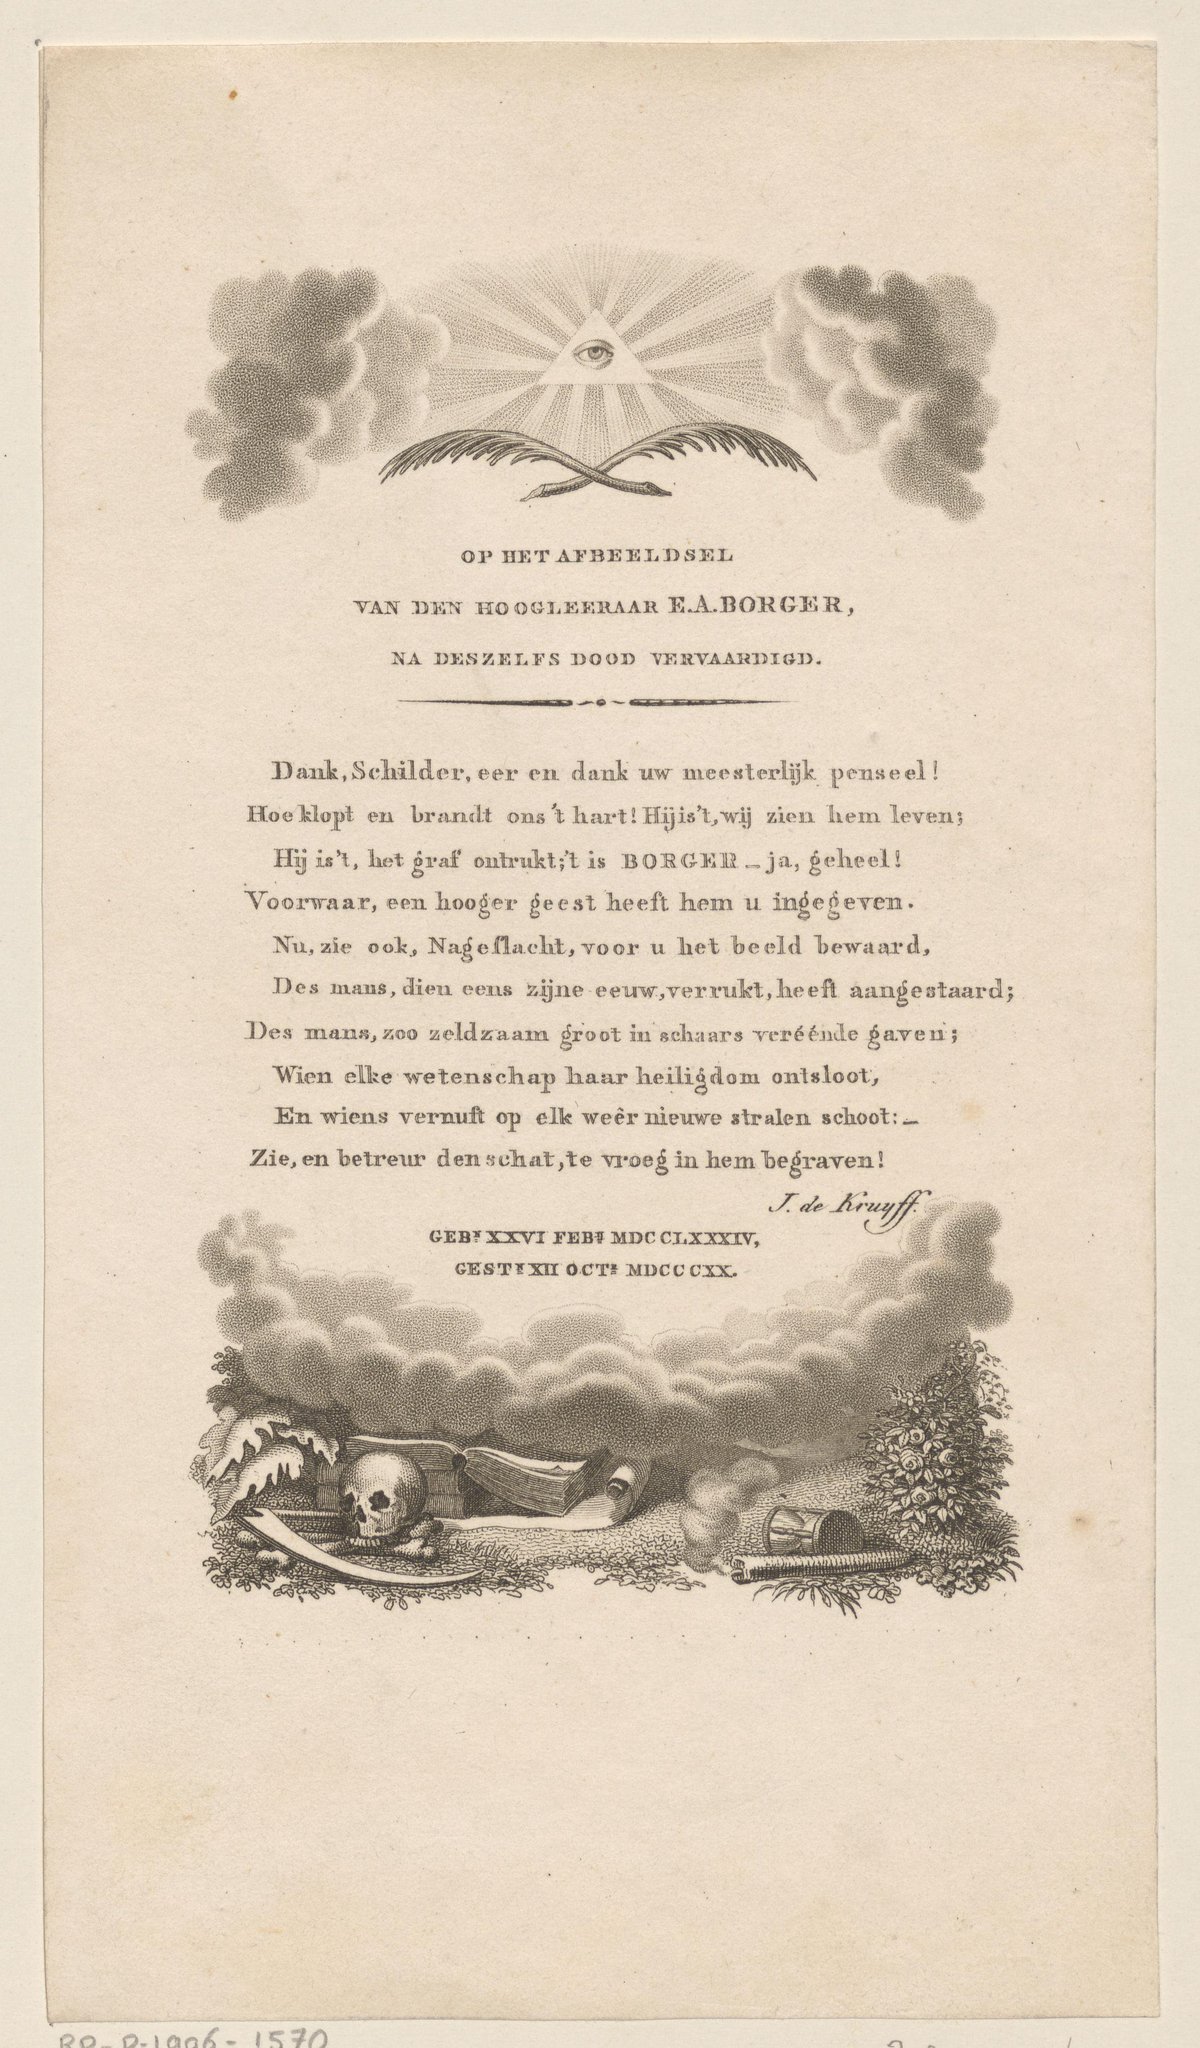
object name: print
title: Gedicht ter nagedachtenis aan Elias Anne Borger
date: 1820-1822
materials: paper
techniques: etching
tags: symbols of death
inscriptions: collector's mark: Lugt 2228